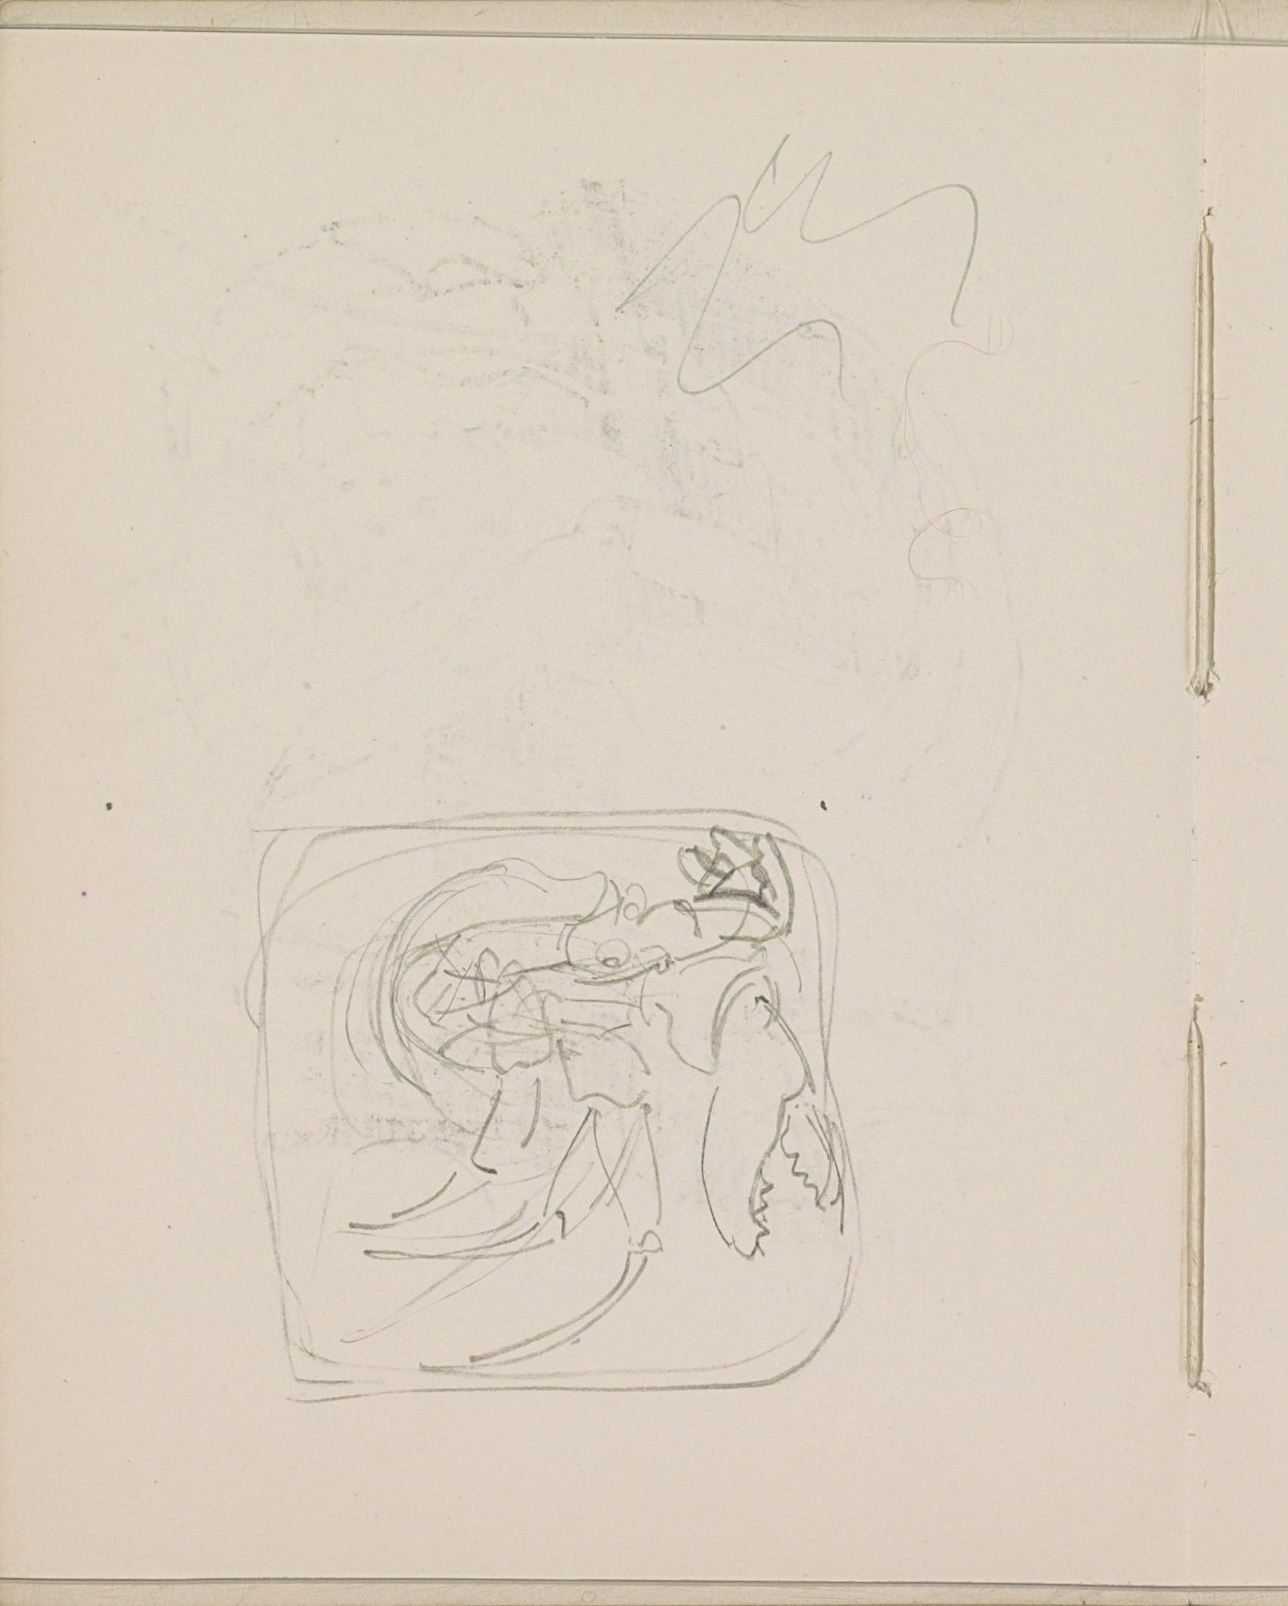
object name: sketchbook leaf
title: Krab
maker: reijer stolk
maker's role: draughtsman, print maker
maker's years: 1896-1945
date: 1916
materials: paper, pencil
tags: crustaceans: crab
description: Blad 23 verso uit een schetsboek met 72 bladen.